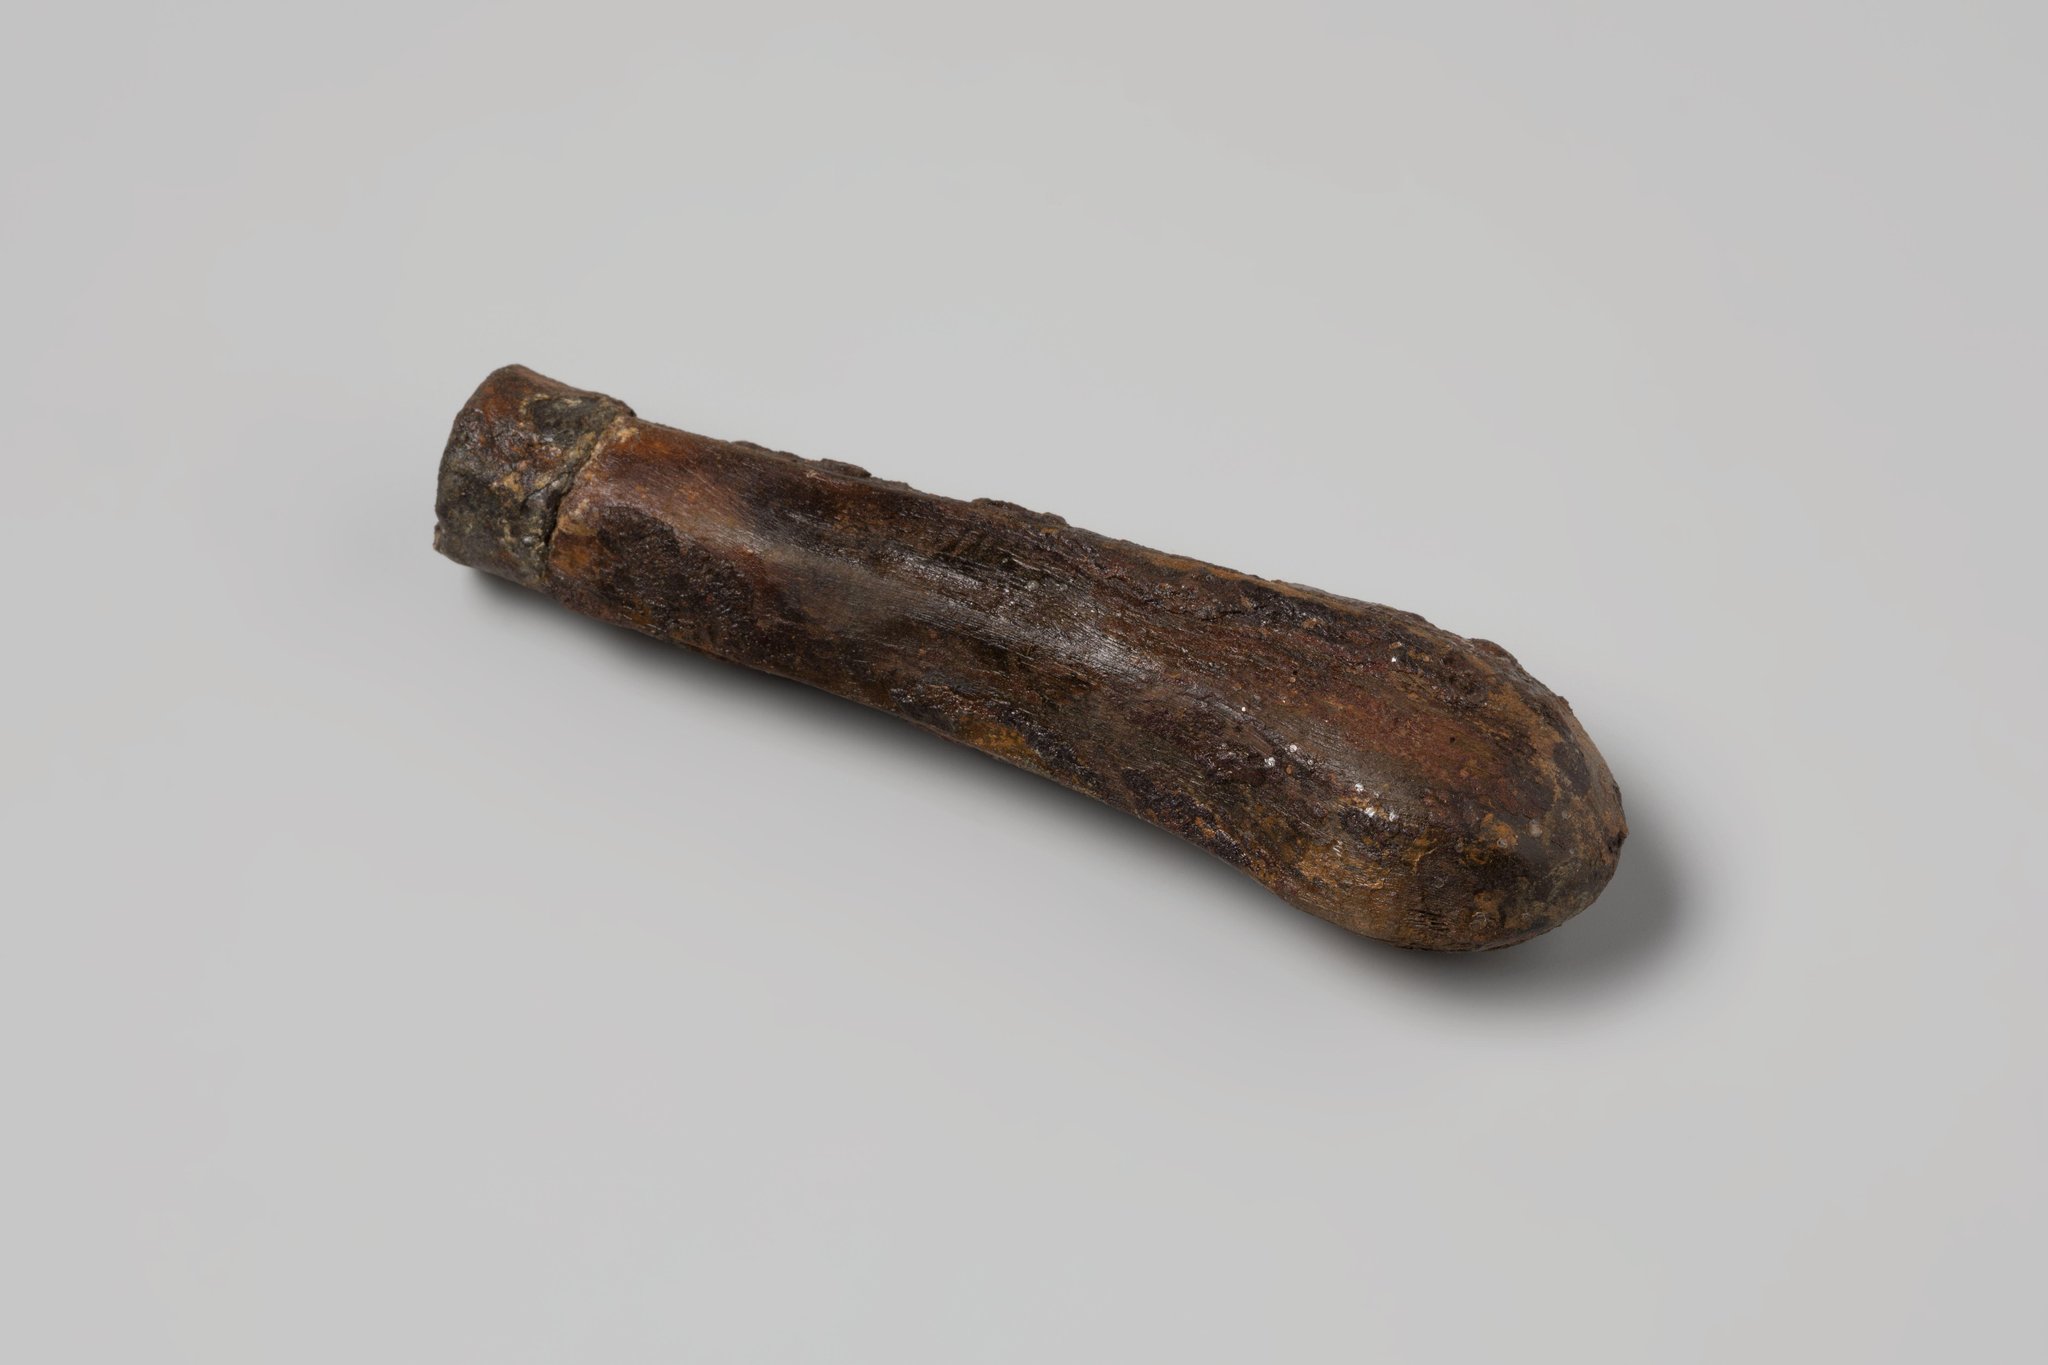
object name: knife tool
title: Messenheft uit het wrak van de Oost-Indiëvaarder Hollandia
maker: Anonymous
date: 1700-1743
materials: metal, wood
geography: netherlands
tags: verenigde oostindische compagnie, hollandia (schip), annet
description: Knife, pistol-grip-shaped id. NG 1979-260H2233, ferrule.